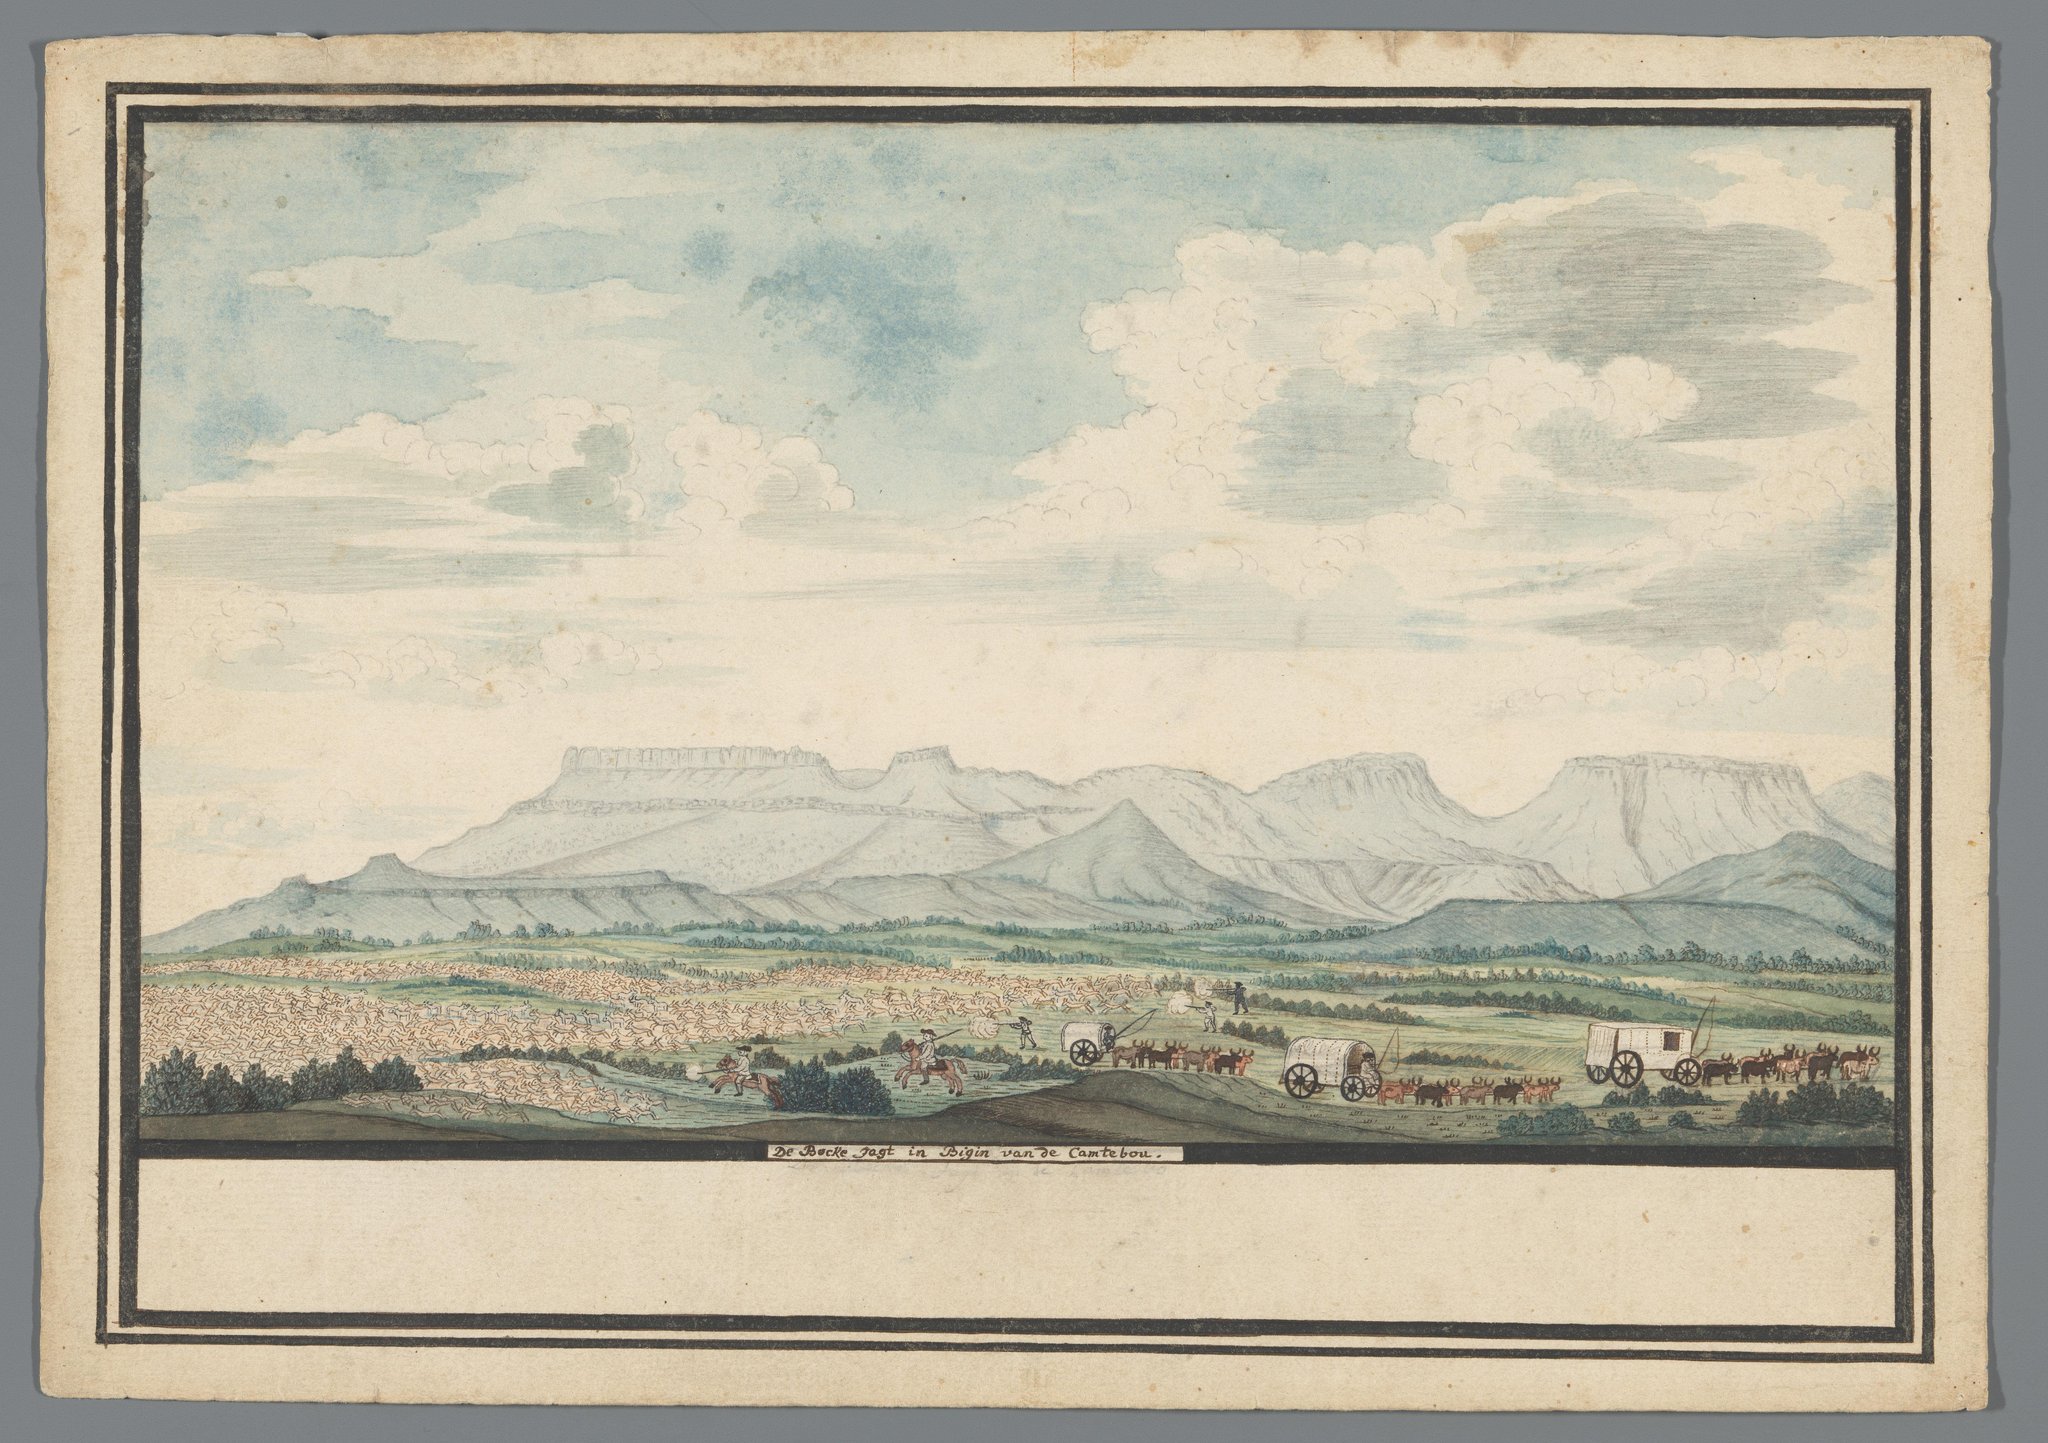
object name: drawing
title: Jacht op springbokken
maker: johannes schumacher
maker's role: draughtsman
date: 1710-1776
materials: paper, watercolor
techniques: brush, pen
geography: south africa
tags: cape of good hope, hoofed animals (with name), hunt ~ hoofed animals, covered wagon, hooded wagon, mountain-range, snow peaks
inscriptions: label: ‘40’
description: Jacht op springbokken in de Camdeboo. In de verte de Sneeuberge. Rechts de ossenwagens. Tekening gemaakt tijdens de tweede reis van Hendrik Swellengrebel, naar het noordoosten van de Kaapkolonie, 10 september - 26 december 1776. Volgens het reisjournaal werd op 8 oktober 1776 door het reisgezelschap gejaagd op springbokken.